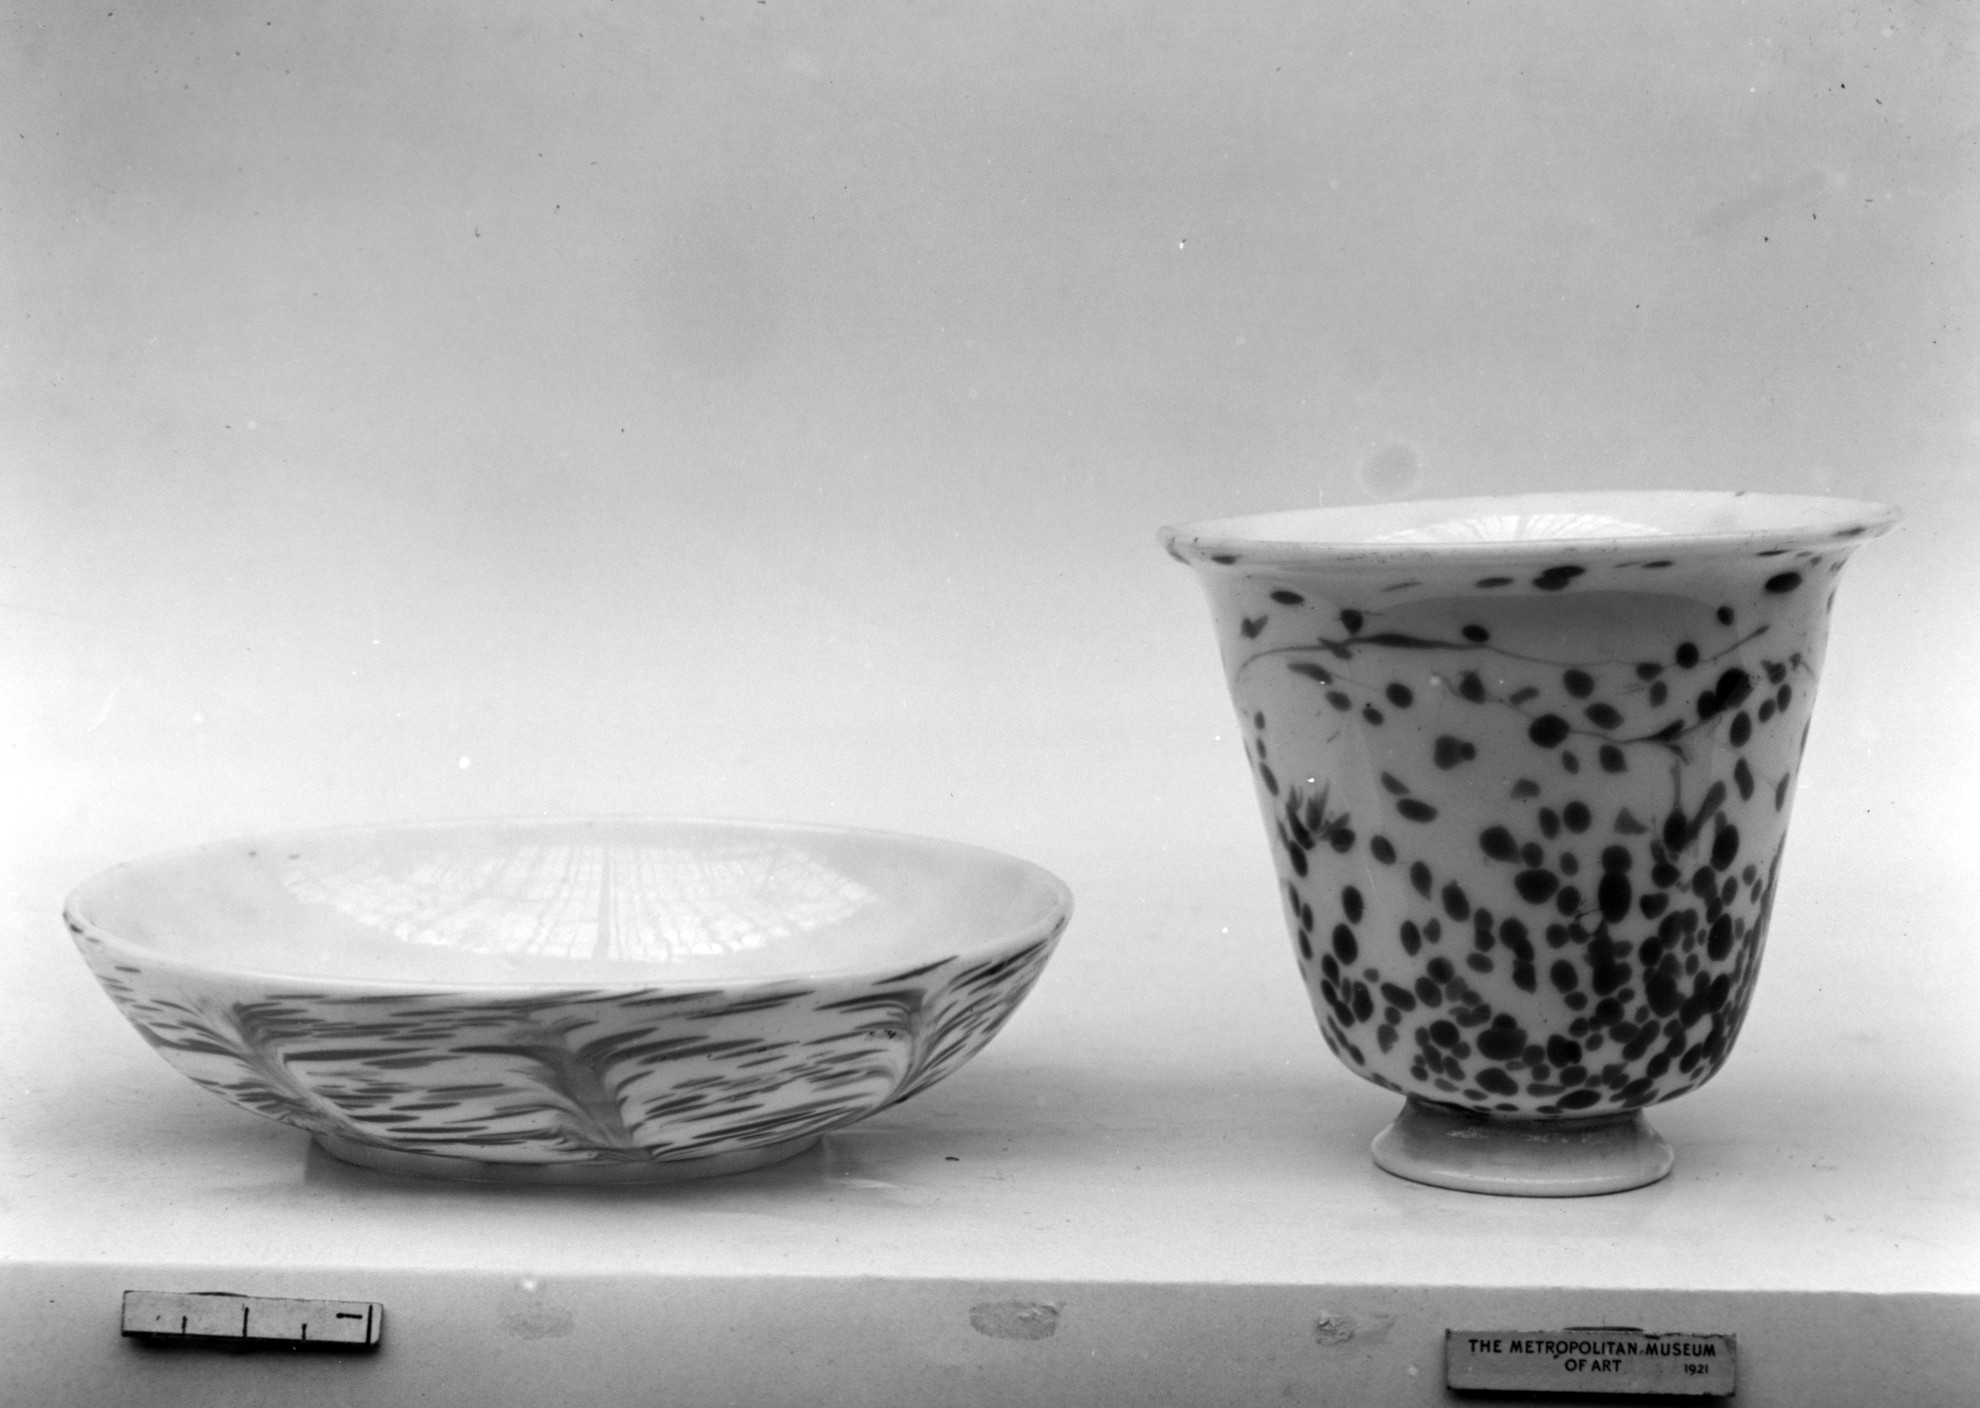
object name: saucer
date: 1701-1750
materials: glass